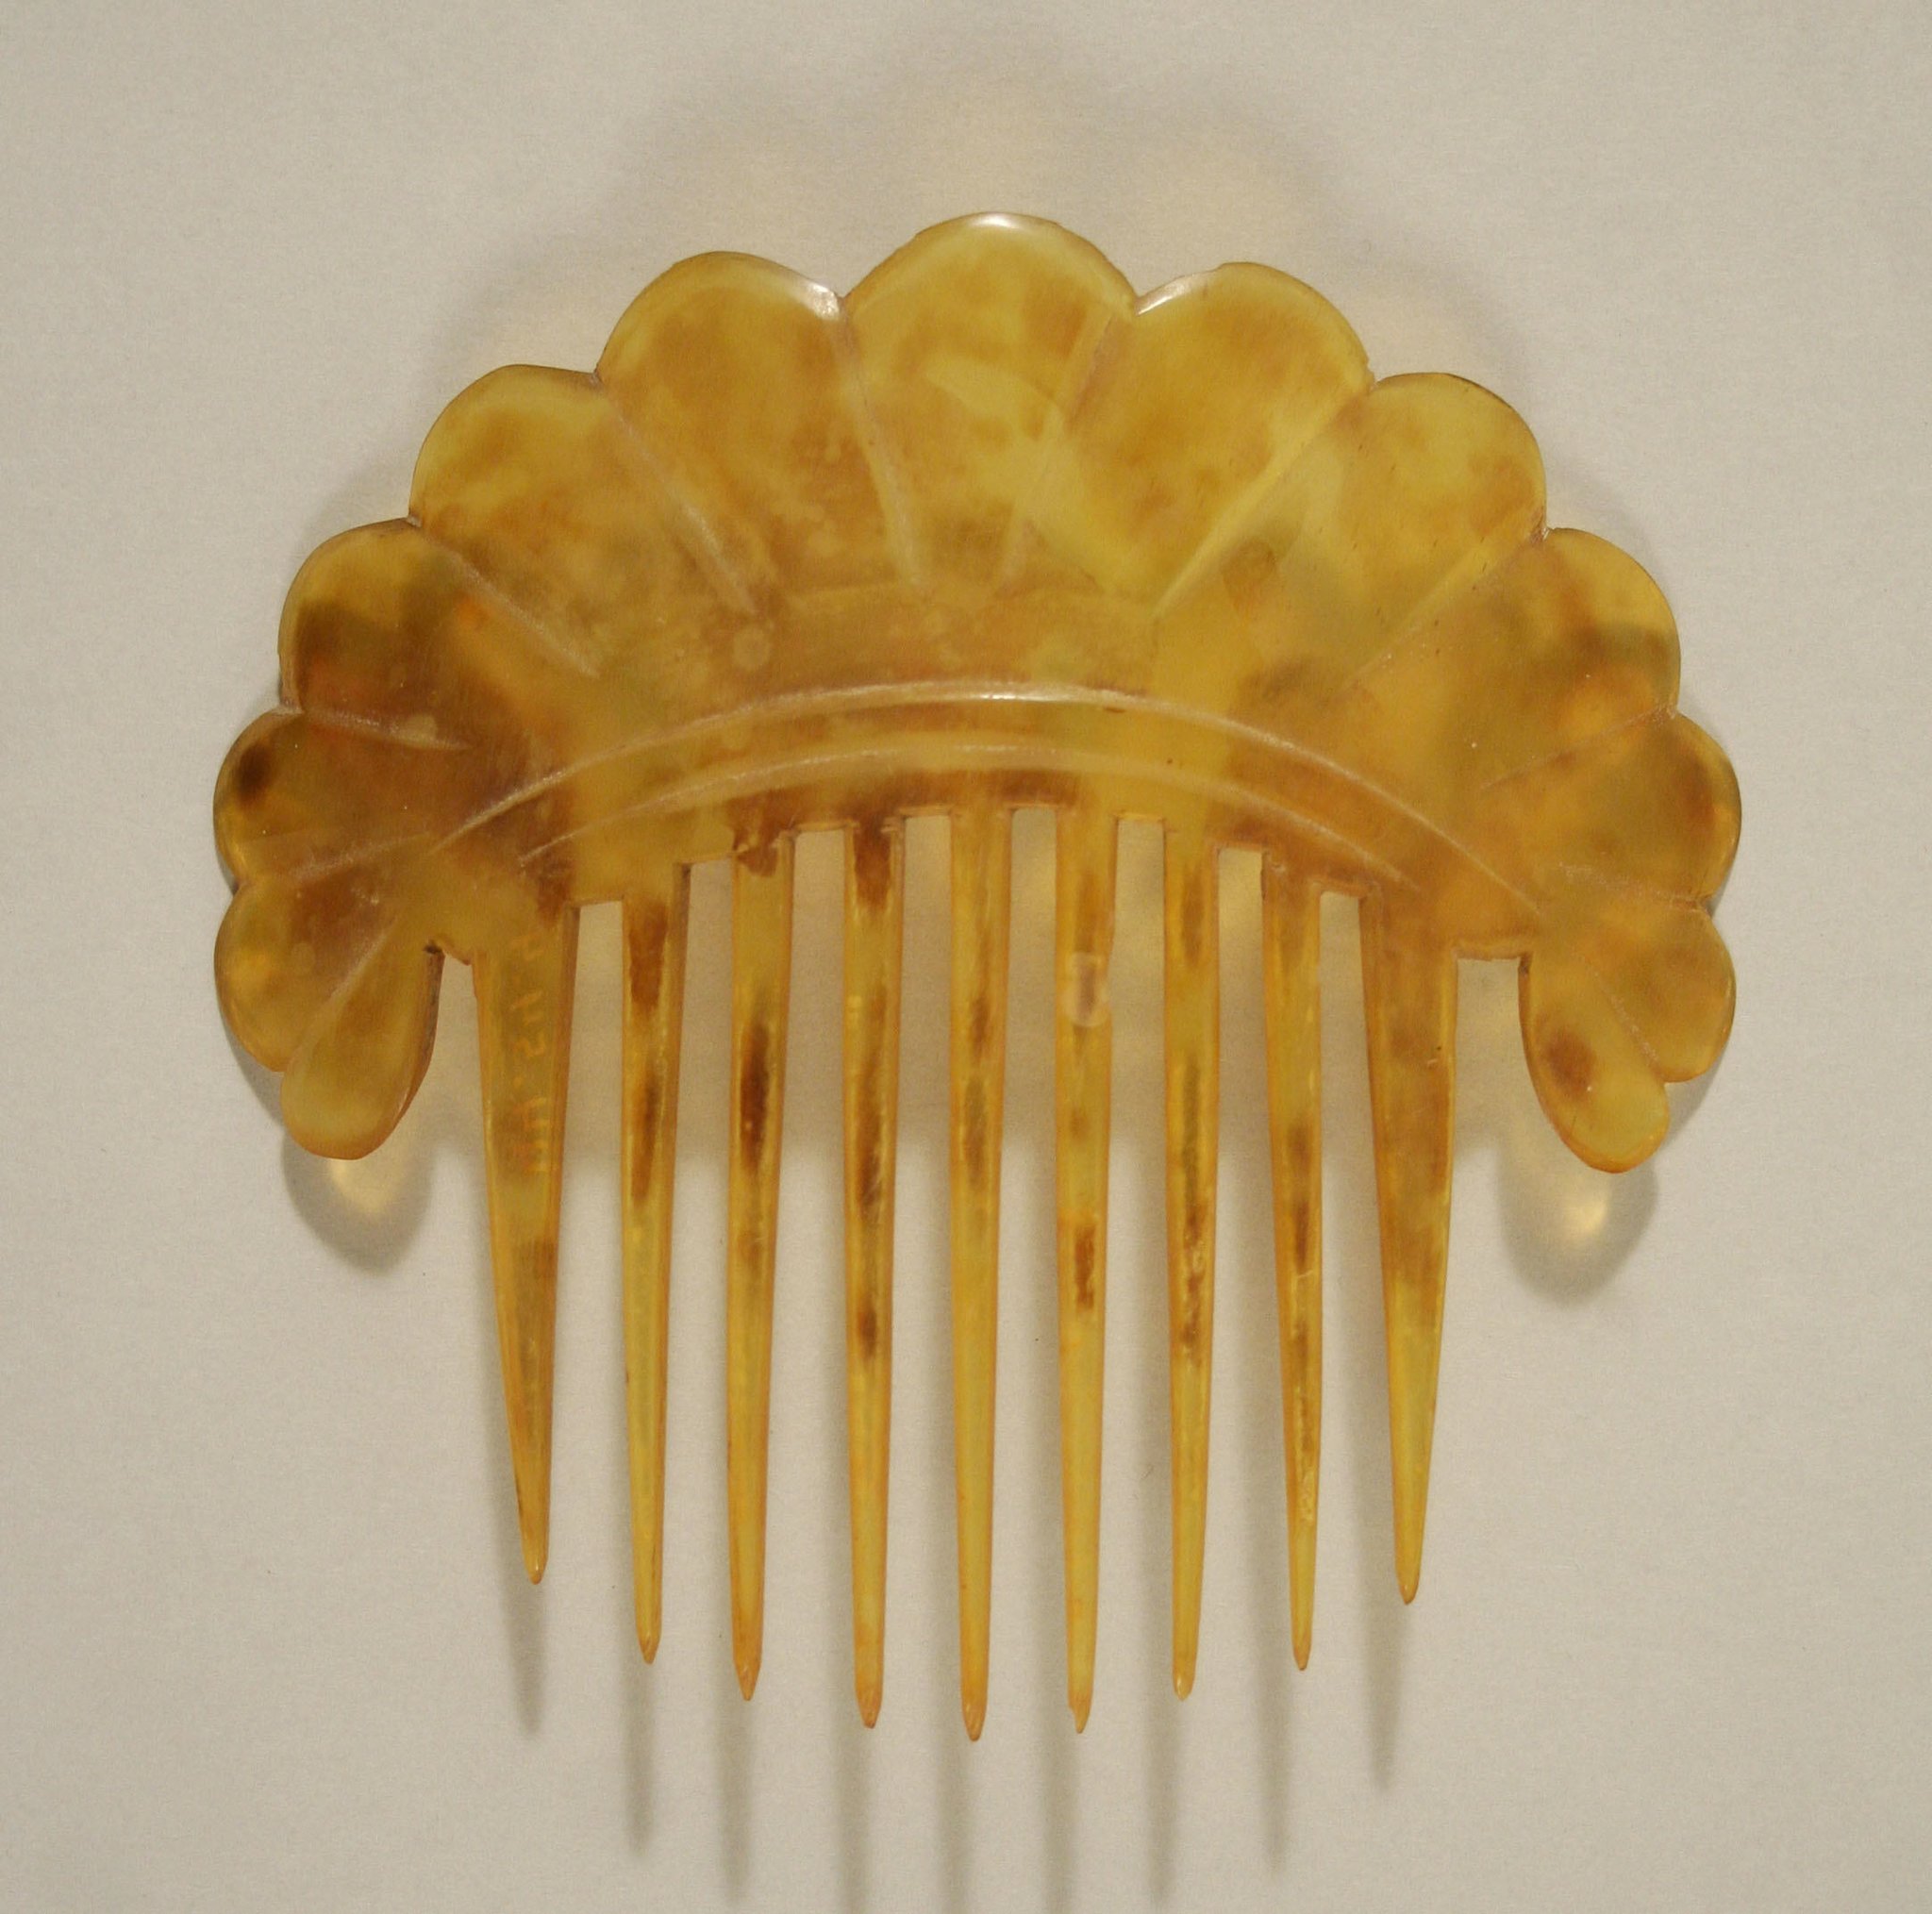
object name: comb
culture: american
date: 1826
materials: plastic